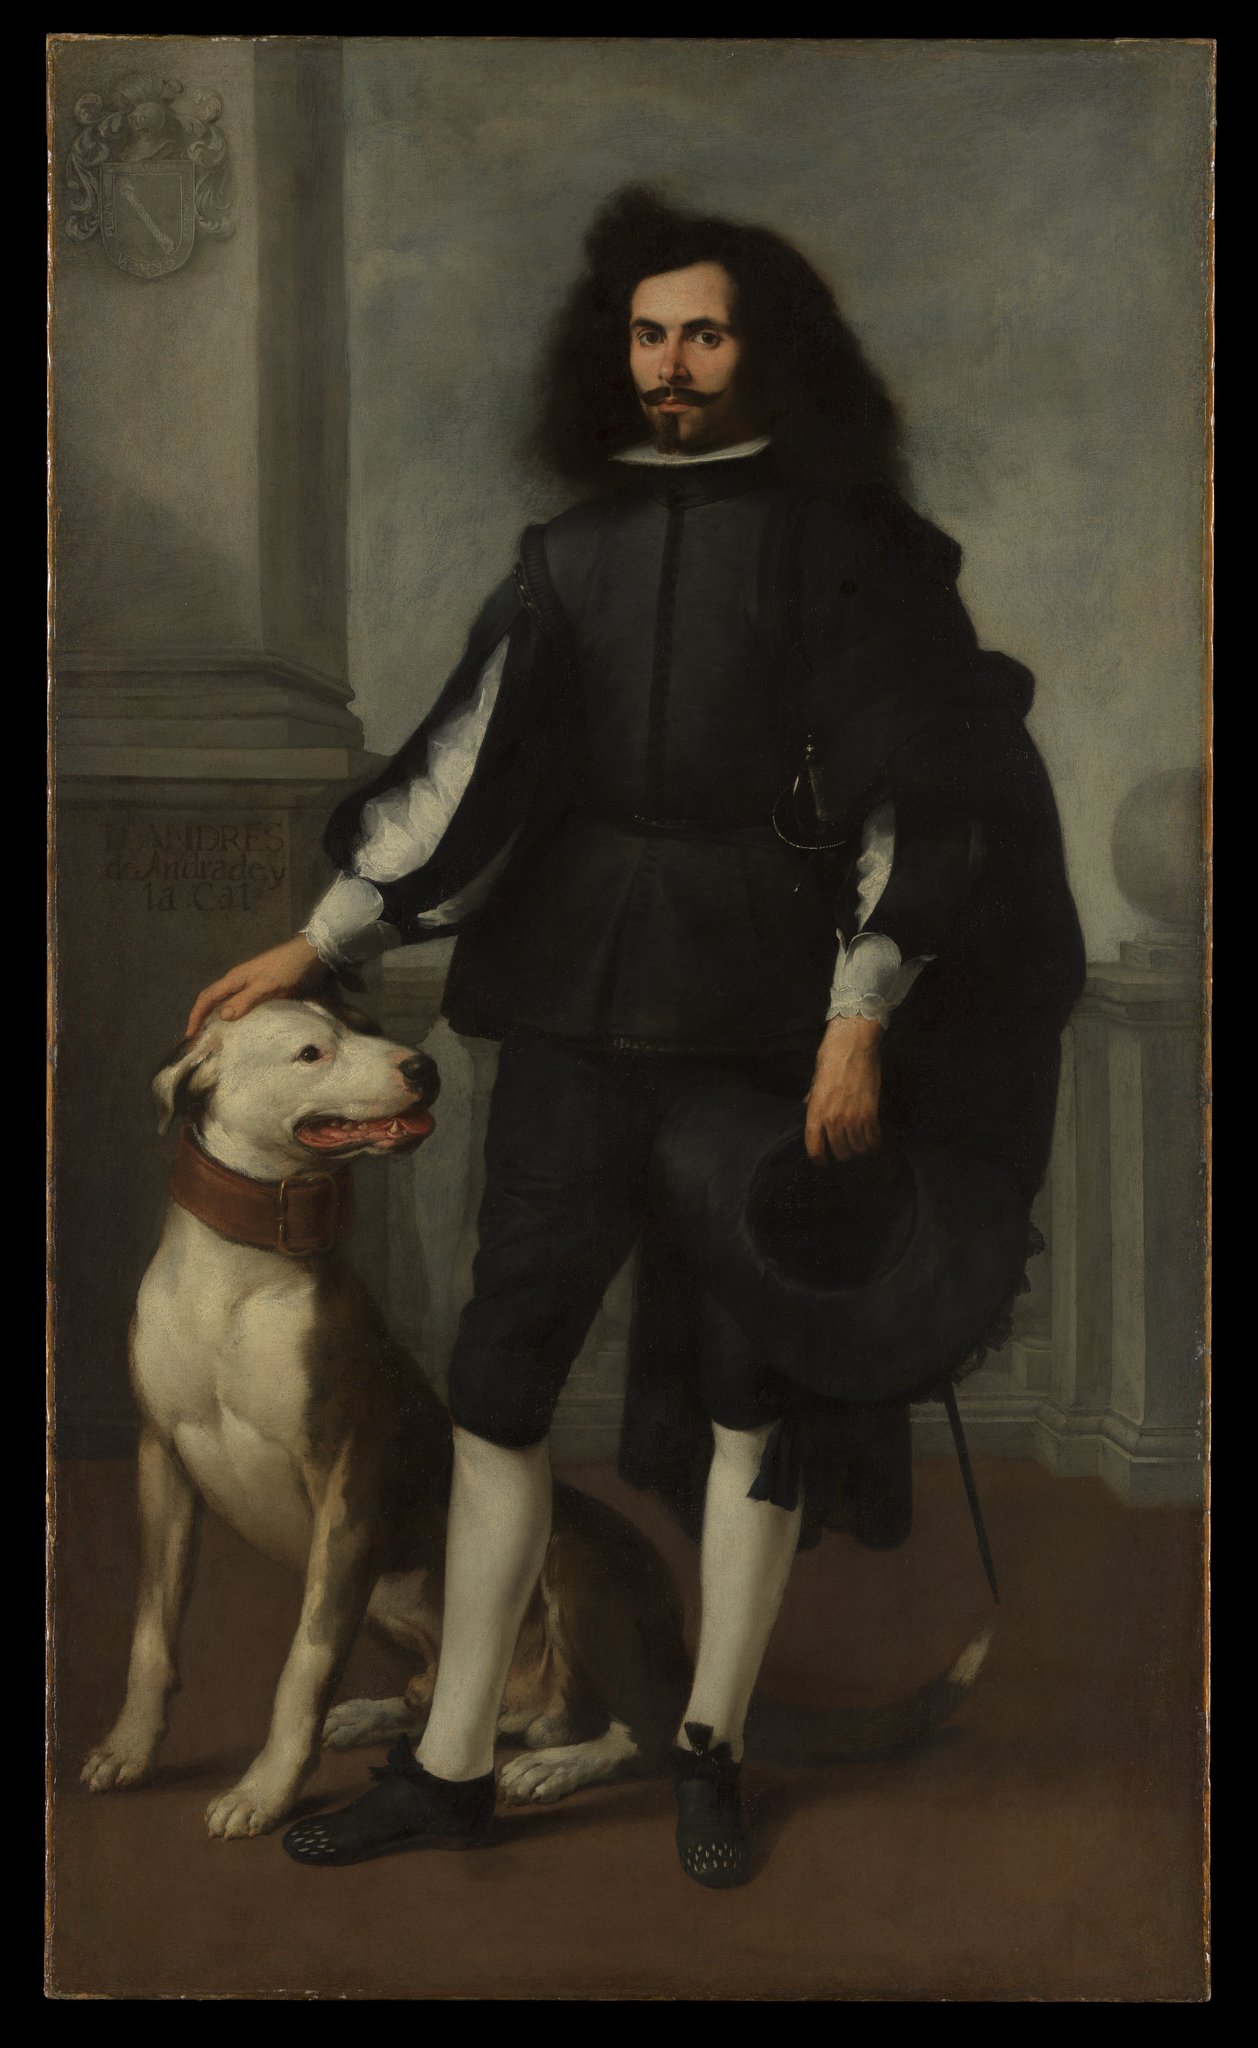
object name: painting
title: Don Andrés de Andrade y la Cal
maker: bartolomé estebán murillo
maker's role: artist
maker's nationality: spanish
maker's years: 1617-1682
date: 1665-1672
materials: canvas, oil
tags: men,portraits,dogs